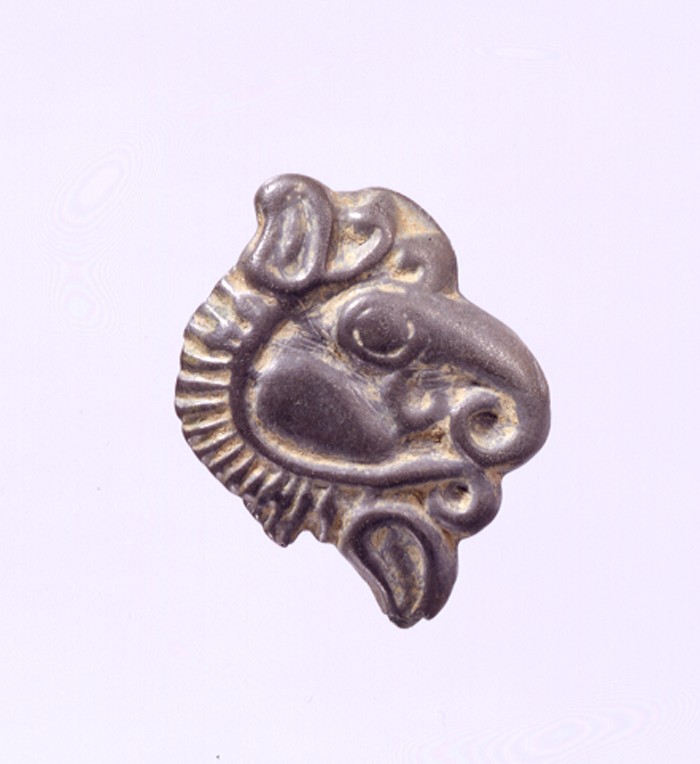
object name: harness ornament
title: Harness Ornament with Bird's Head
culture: bulgarian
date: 434-301 BCE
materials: bronze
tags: birds